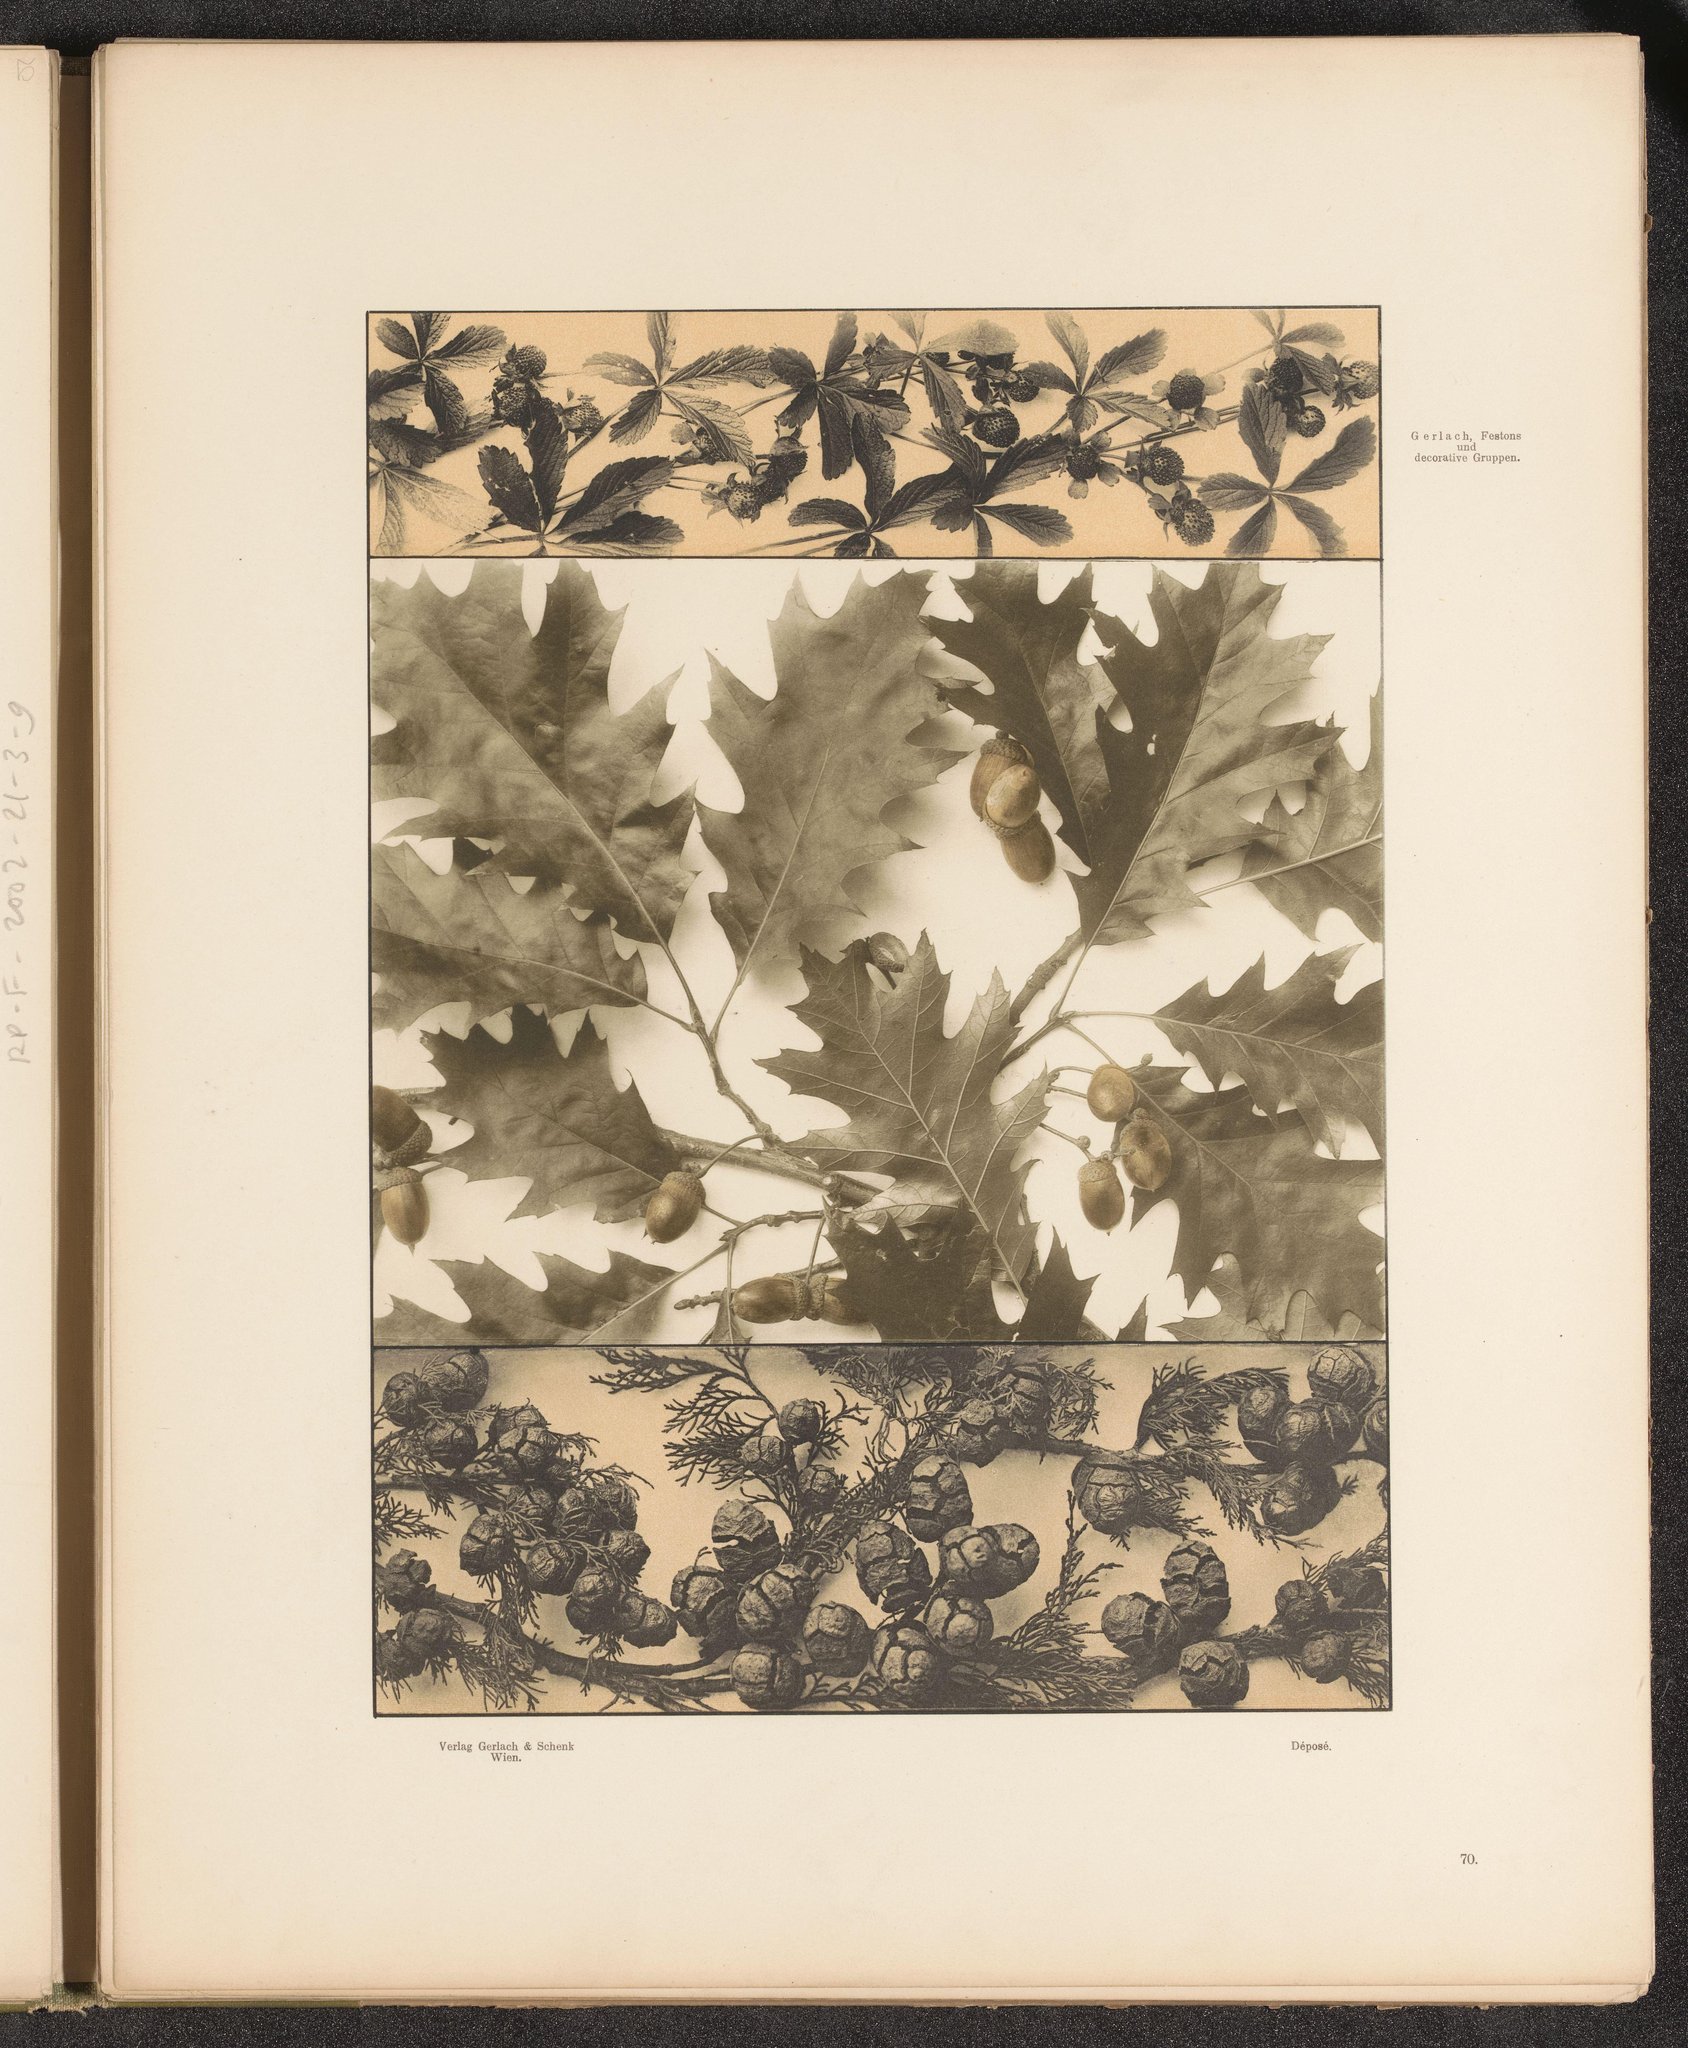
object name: photomechanical print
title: Vlakken met aardbeien, eikenbladeren en cipressen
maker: Anonymous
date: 1887-1897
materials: paper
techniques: photograph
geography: austria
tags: fruits: strawberry, trees: oak (+ leaf), trees: cypress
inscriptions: number: ‘70.’